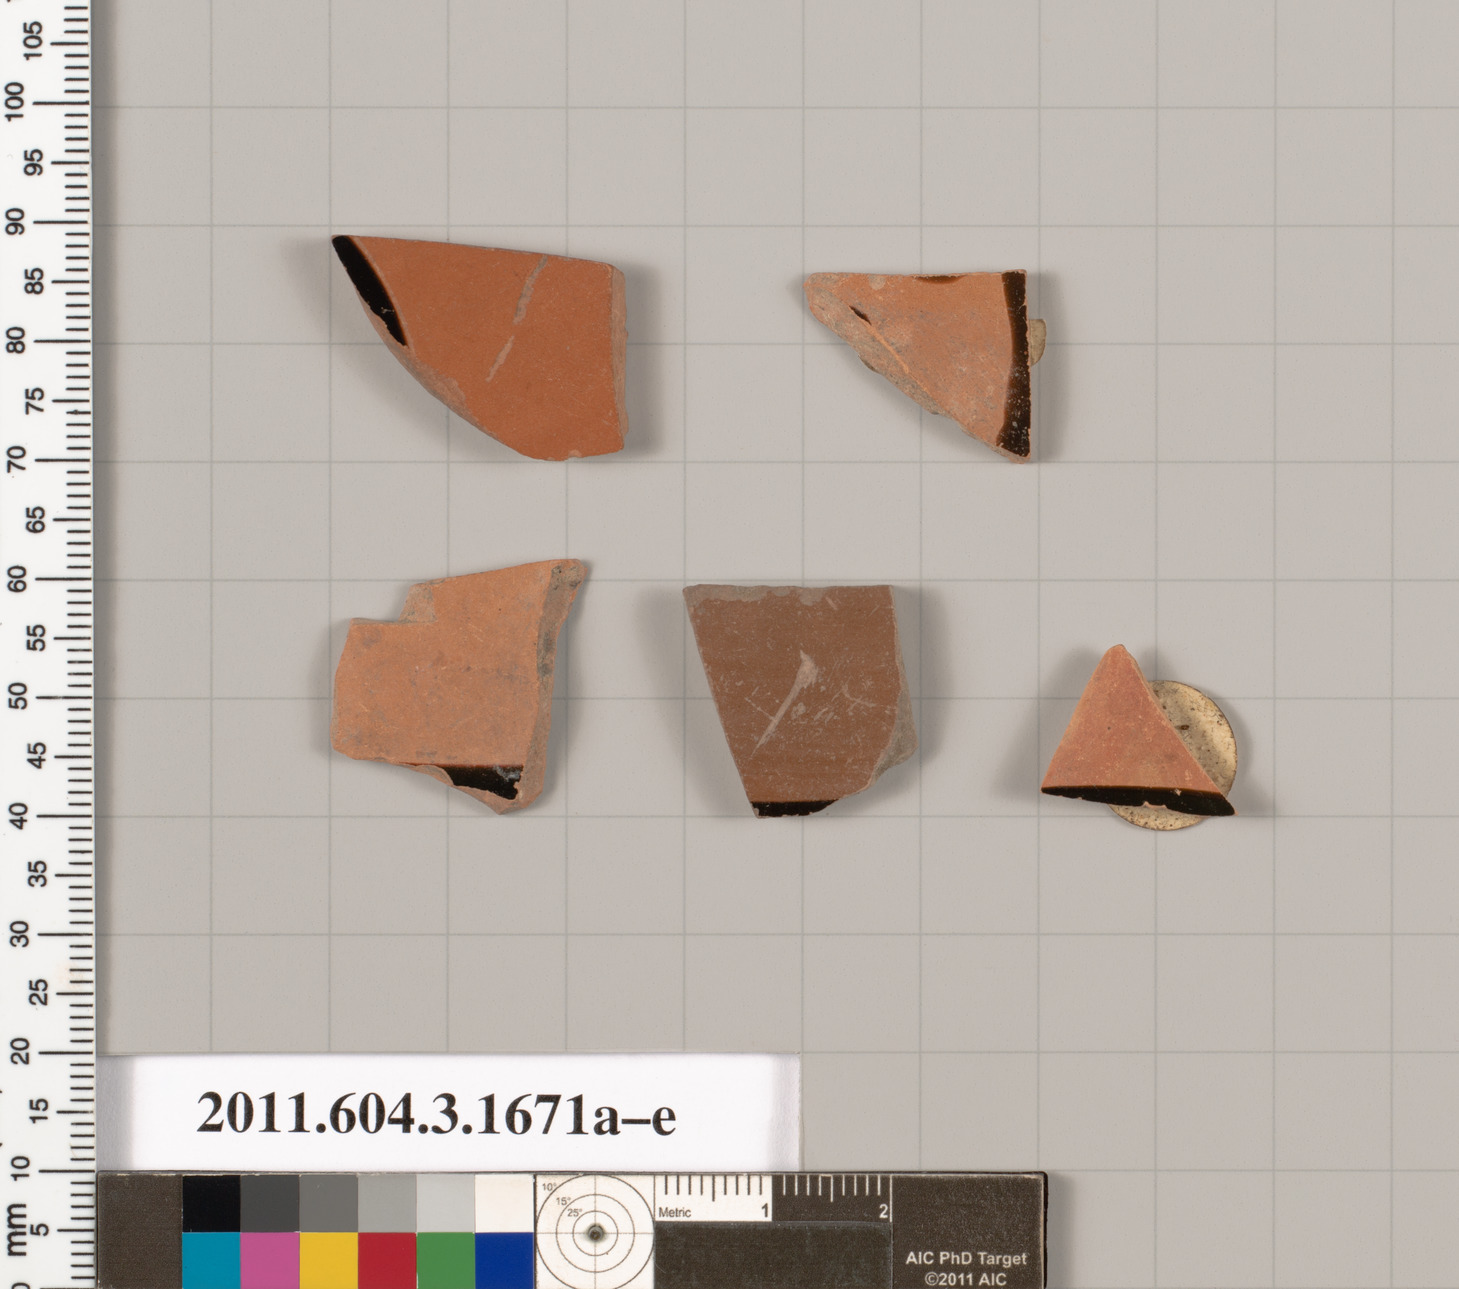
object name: kylix fragment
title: Terracotta fragments of kylikes: Band or lip cups (drinking cups)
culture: greek, attic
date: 550-526 BCE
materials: terracotta